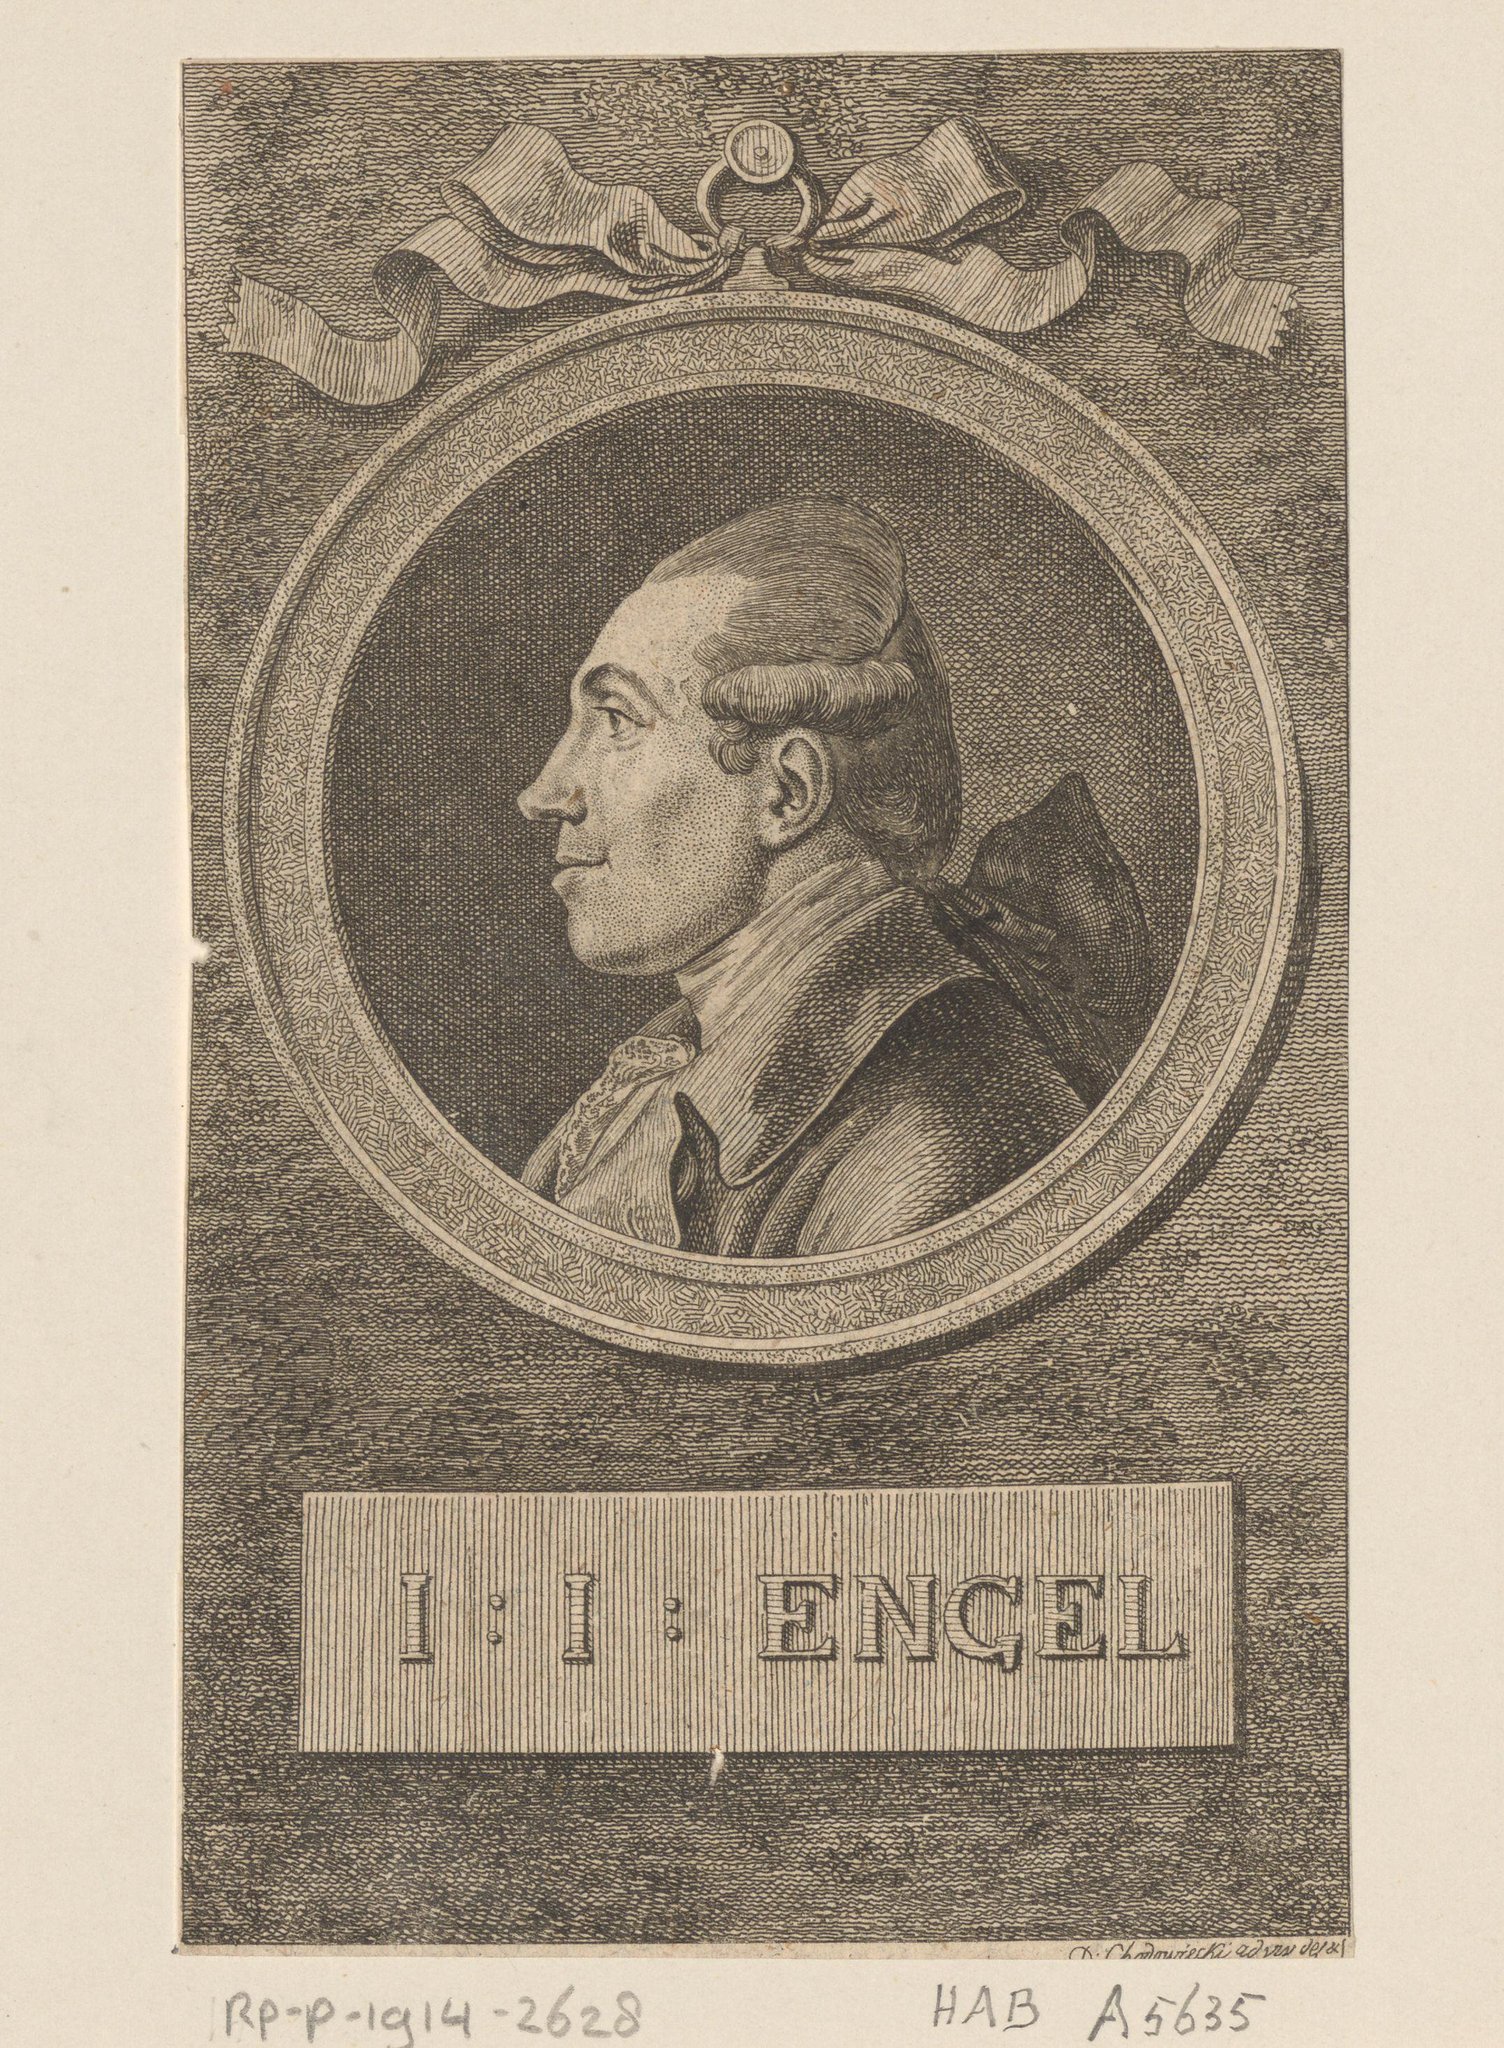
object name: print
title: Portret van Johann Jacob Engel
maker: daniel nikolaus chodowiecki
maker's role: draughtsman, print maker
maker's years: 1726-1801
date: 1779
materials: paper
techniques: etching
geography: berlin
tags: historical persons, portrait of a writer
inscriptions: collector's mark: Lugt 2228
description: Prent waarschijnlijk uit: Allgemeine Deutsche Bibliothek, vol. 39, dl. 1, 1779.